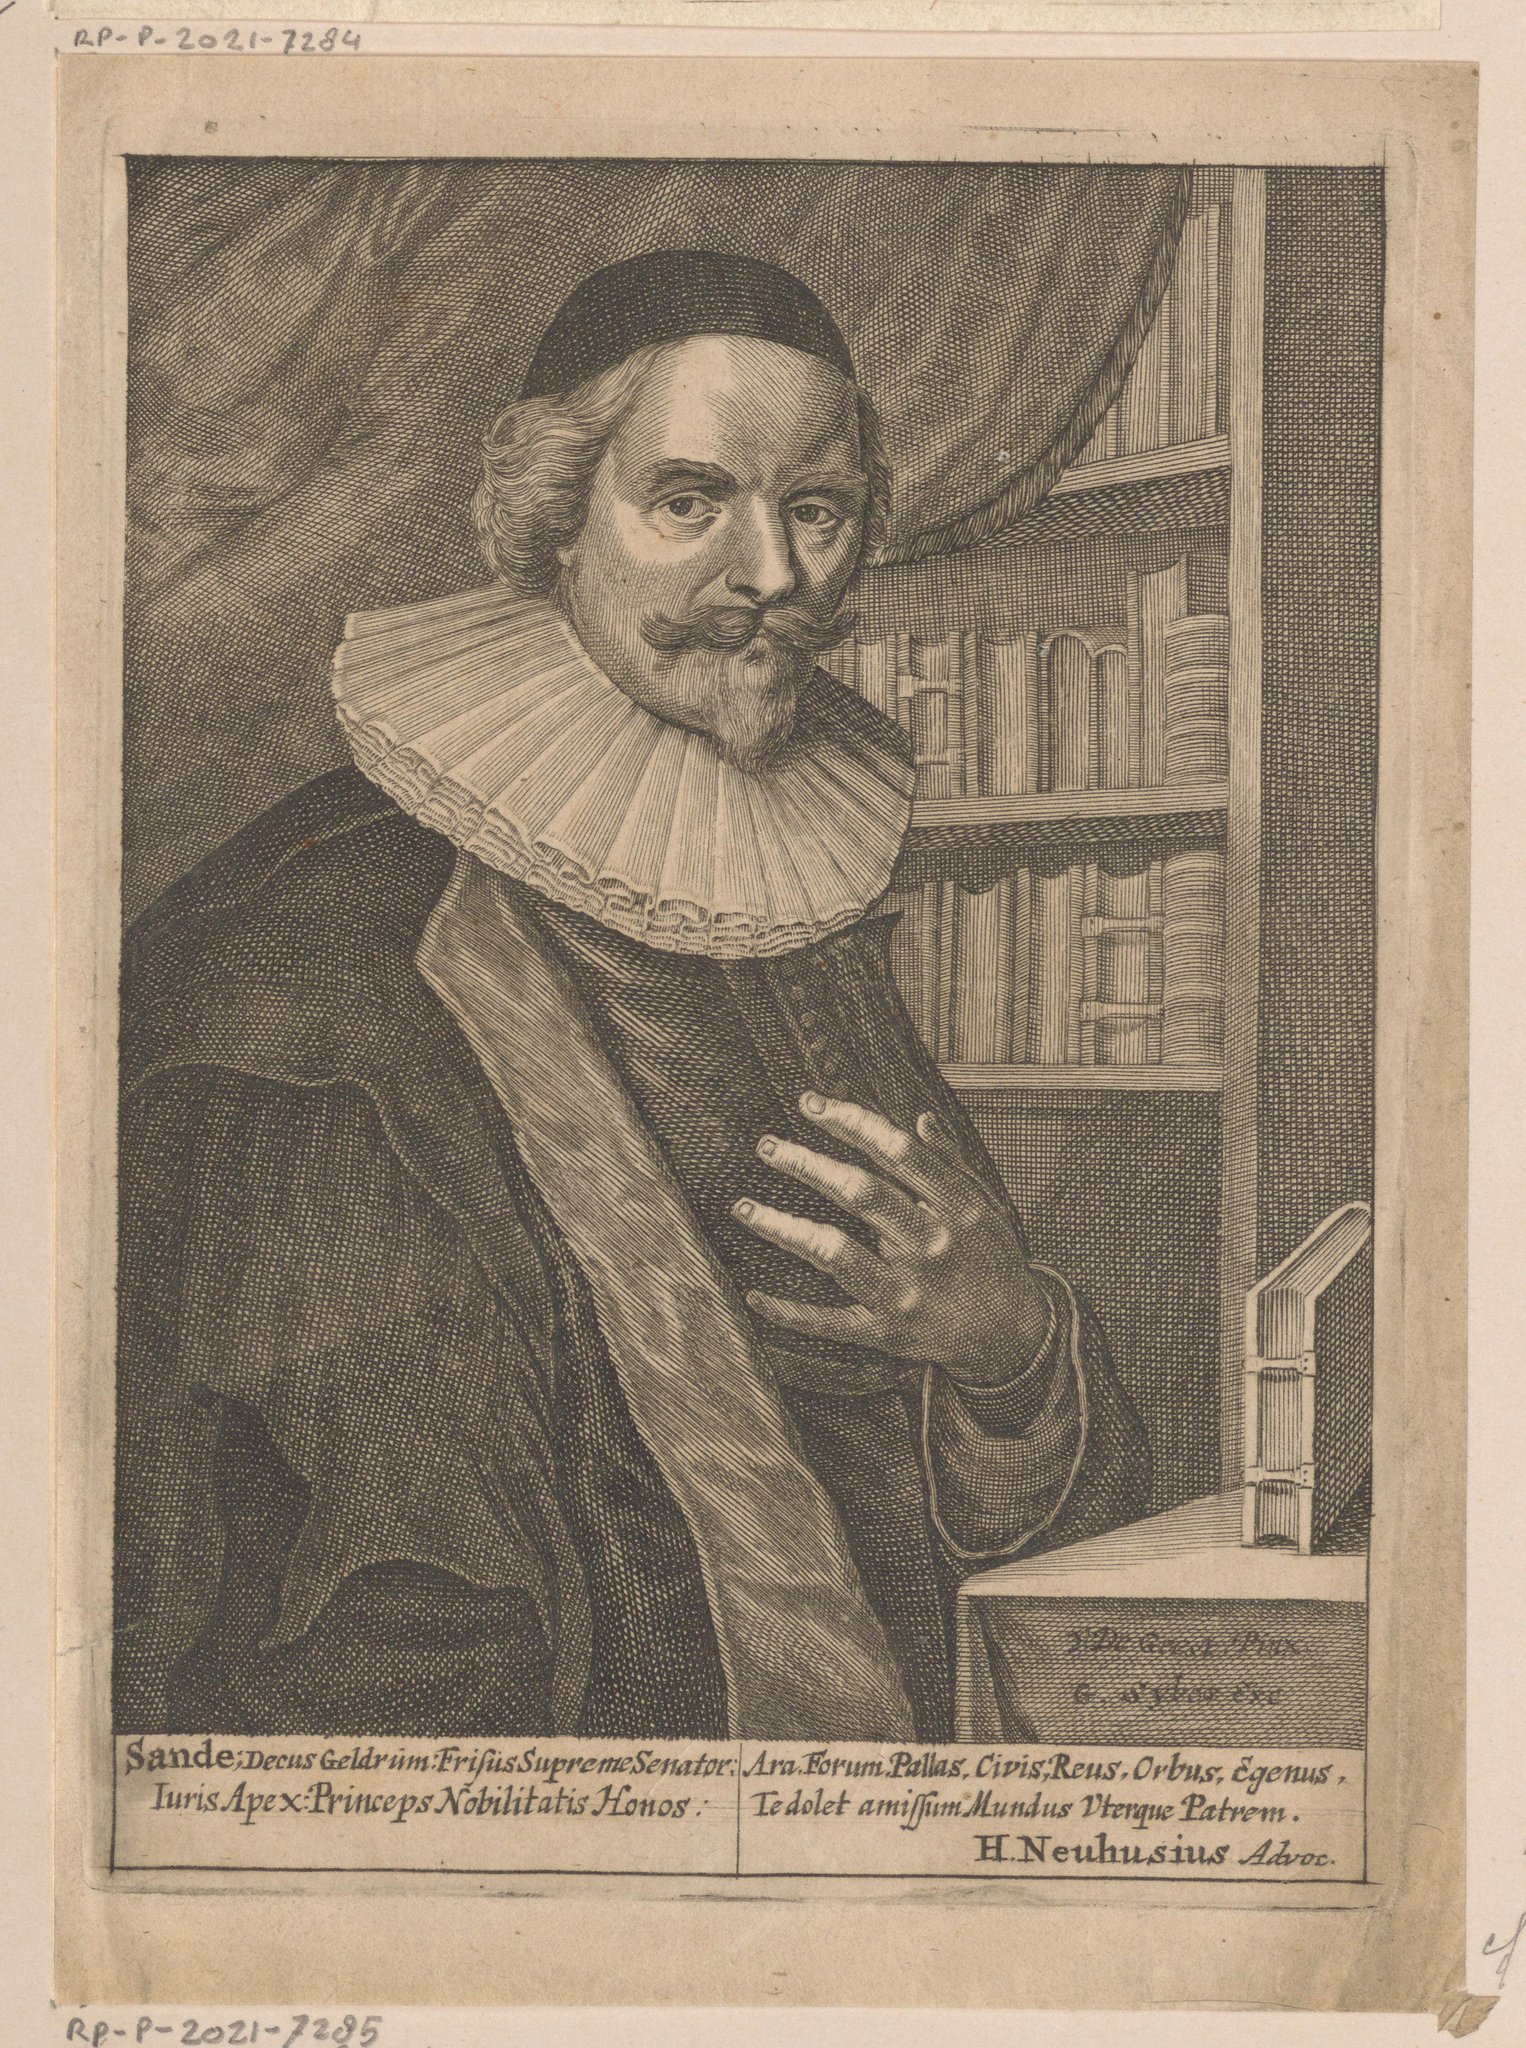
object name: print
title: Portret van Johan van den Sande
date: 1638-1660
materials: paper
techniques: engraving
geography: leeuwarden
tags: arnhem, johan van den sande, historical persons, portrait of a writer, book